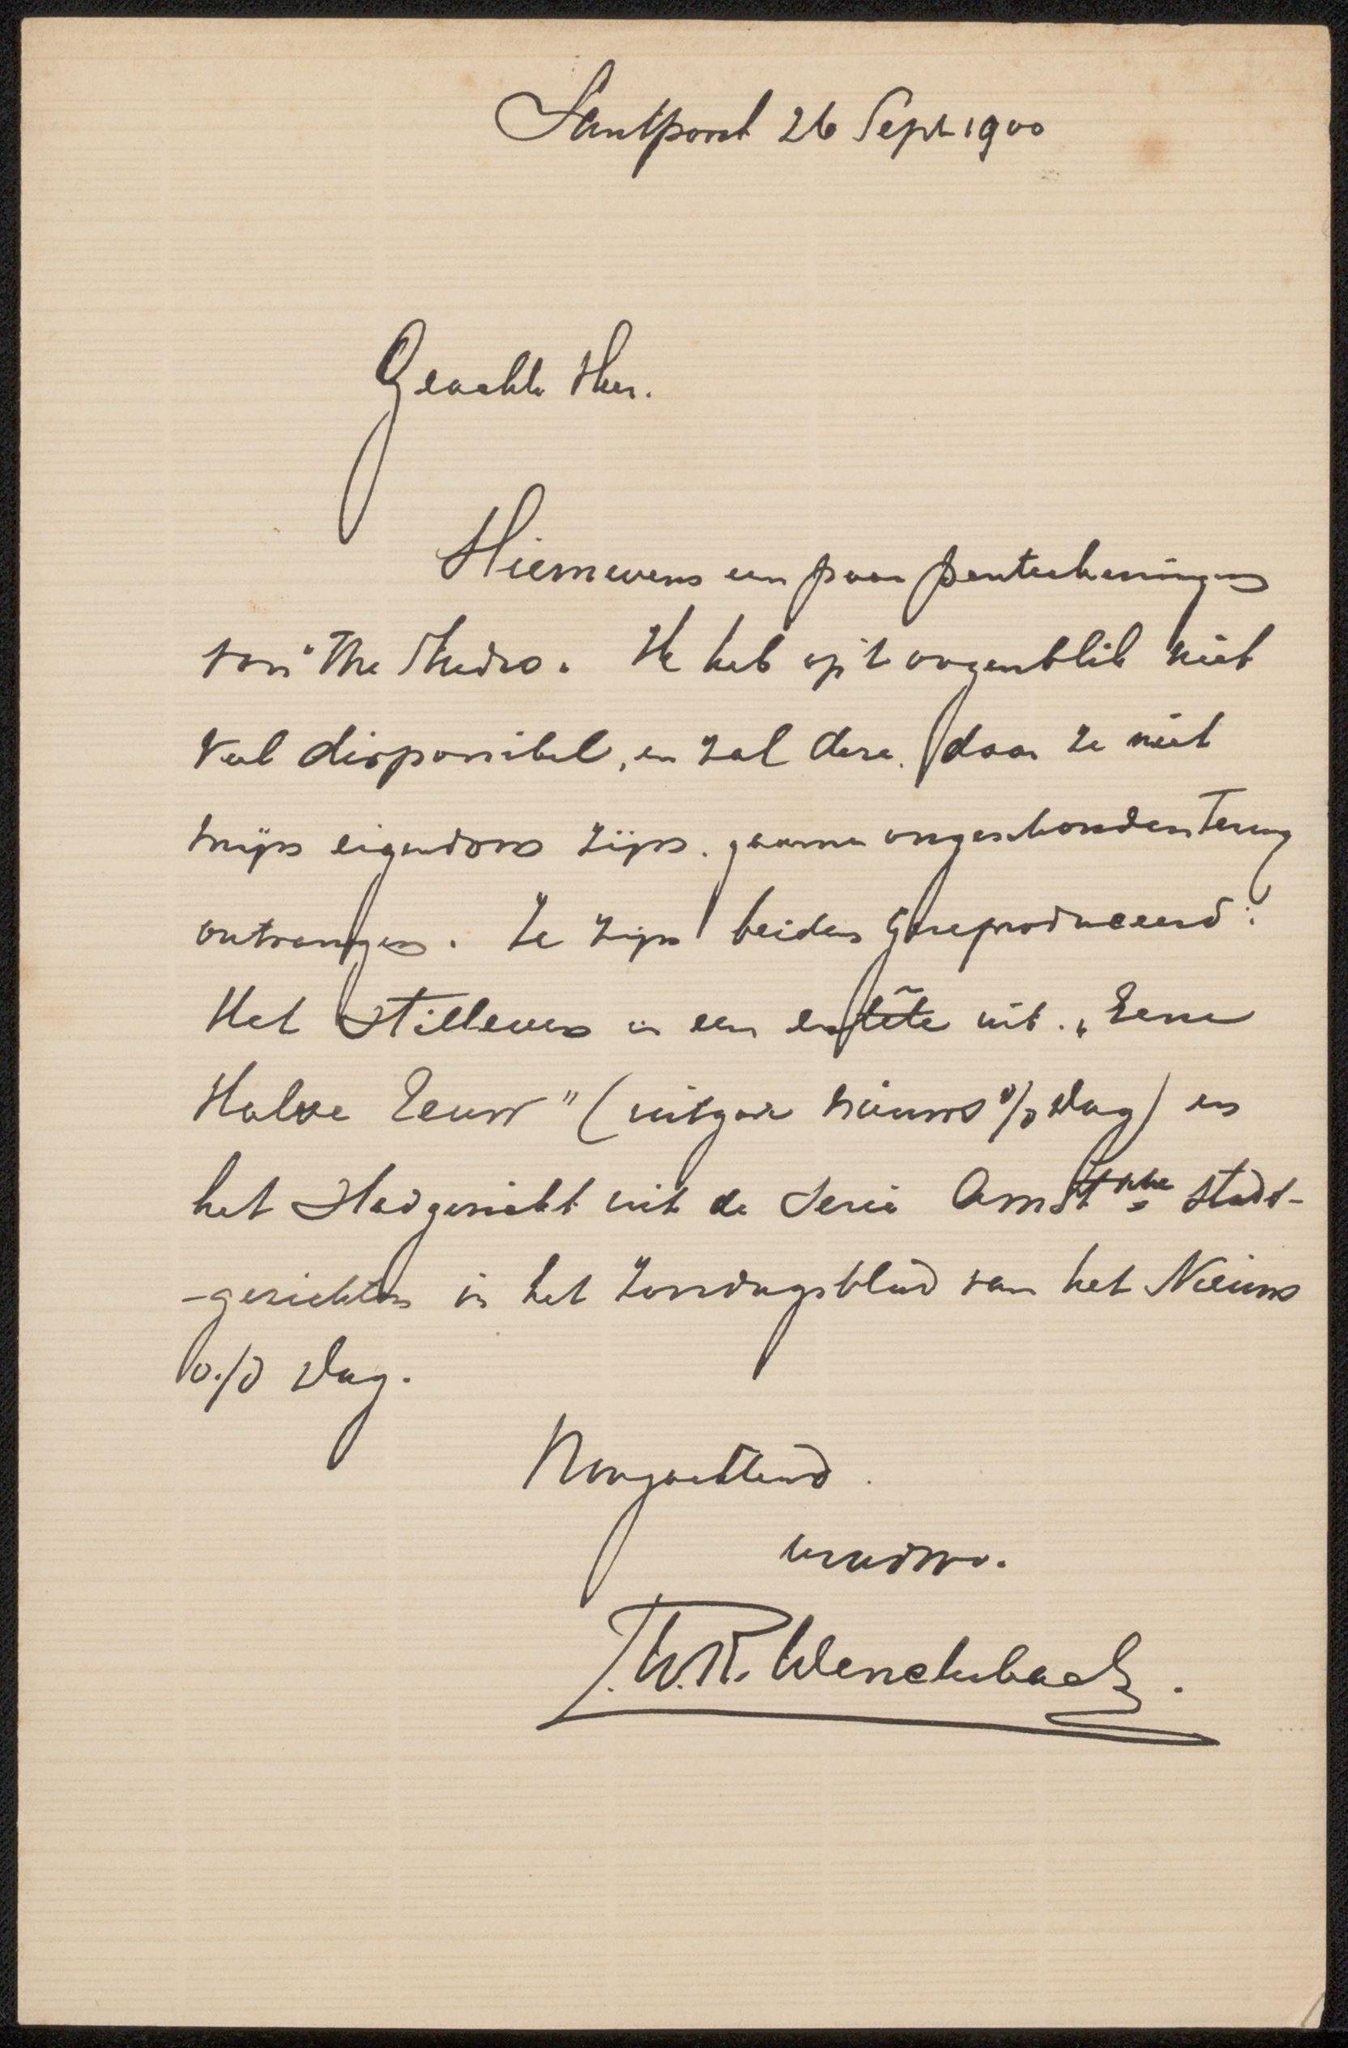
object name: letter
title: Brief aan Philip Zilcken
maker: willem wenckebach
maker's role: designer, draughtsman, painter, print maker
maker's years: 1860-1937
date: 1900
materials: ink, paper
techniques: pen, writing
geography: santpoort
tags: publisher, painter, draughtsman, philip zilcken, drawing, illustration ~ printed matter, book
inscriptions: collector's mark: ‘RPK’